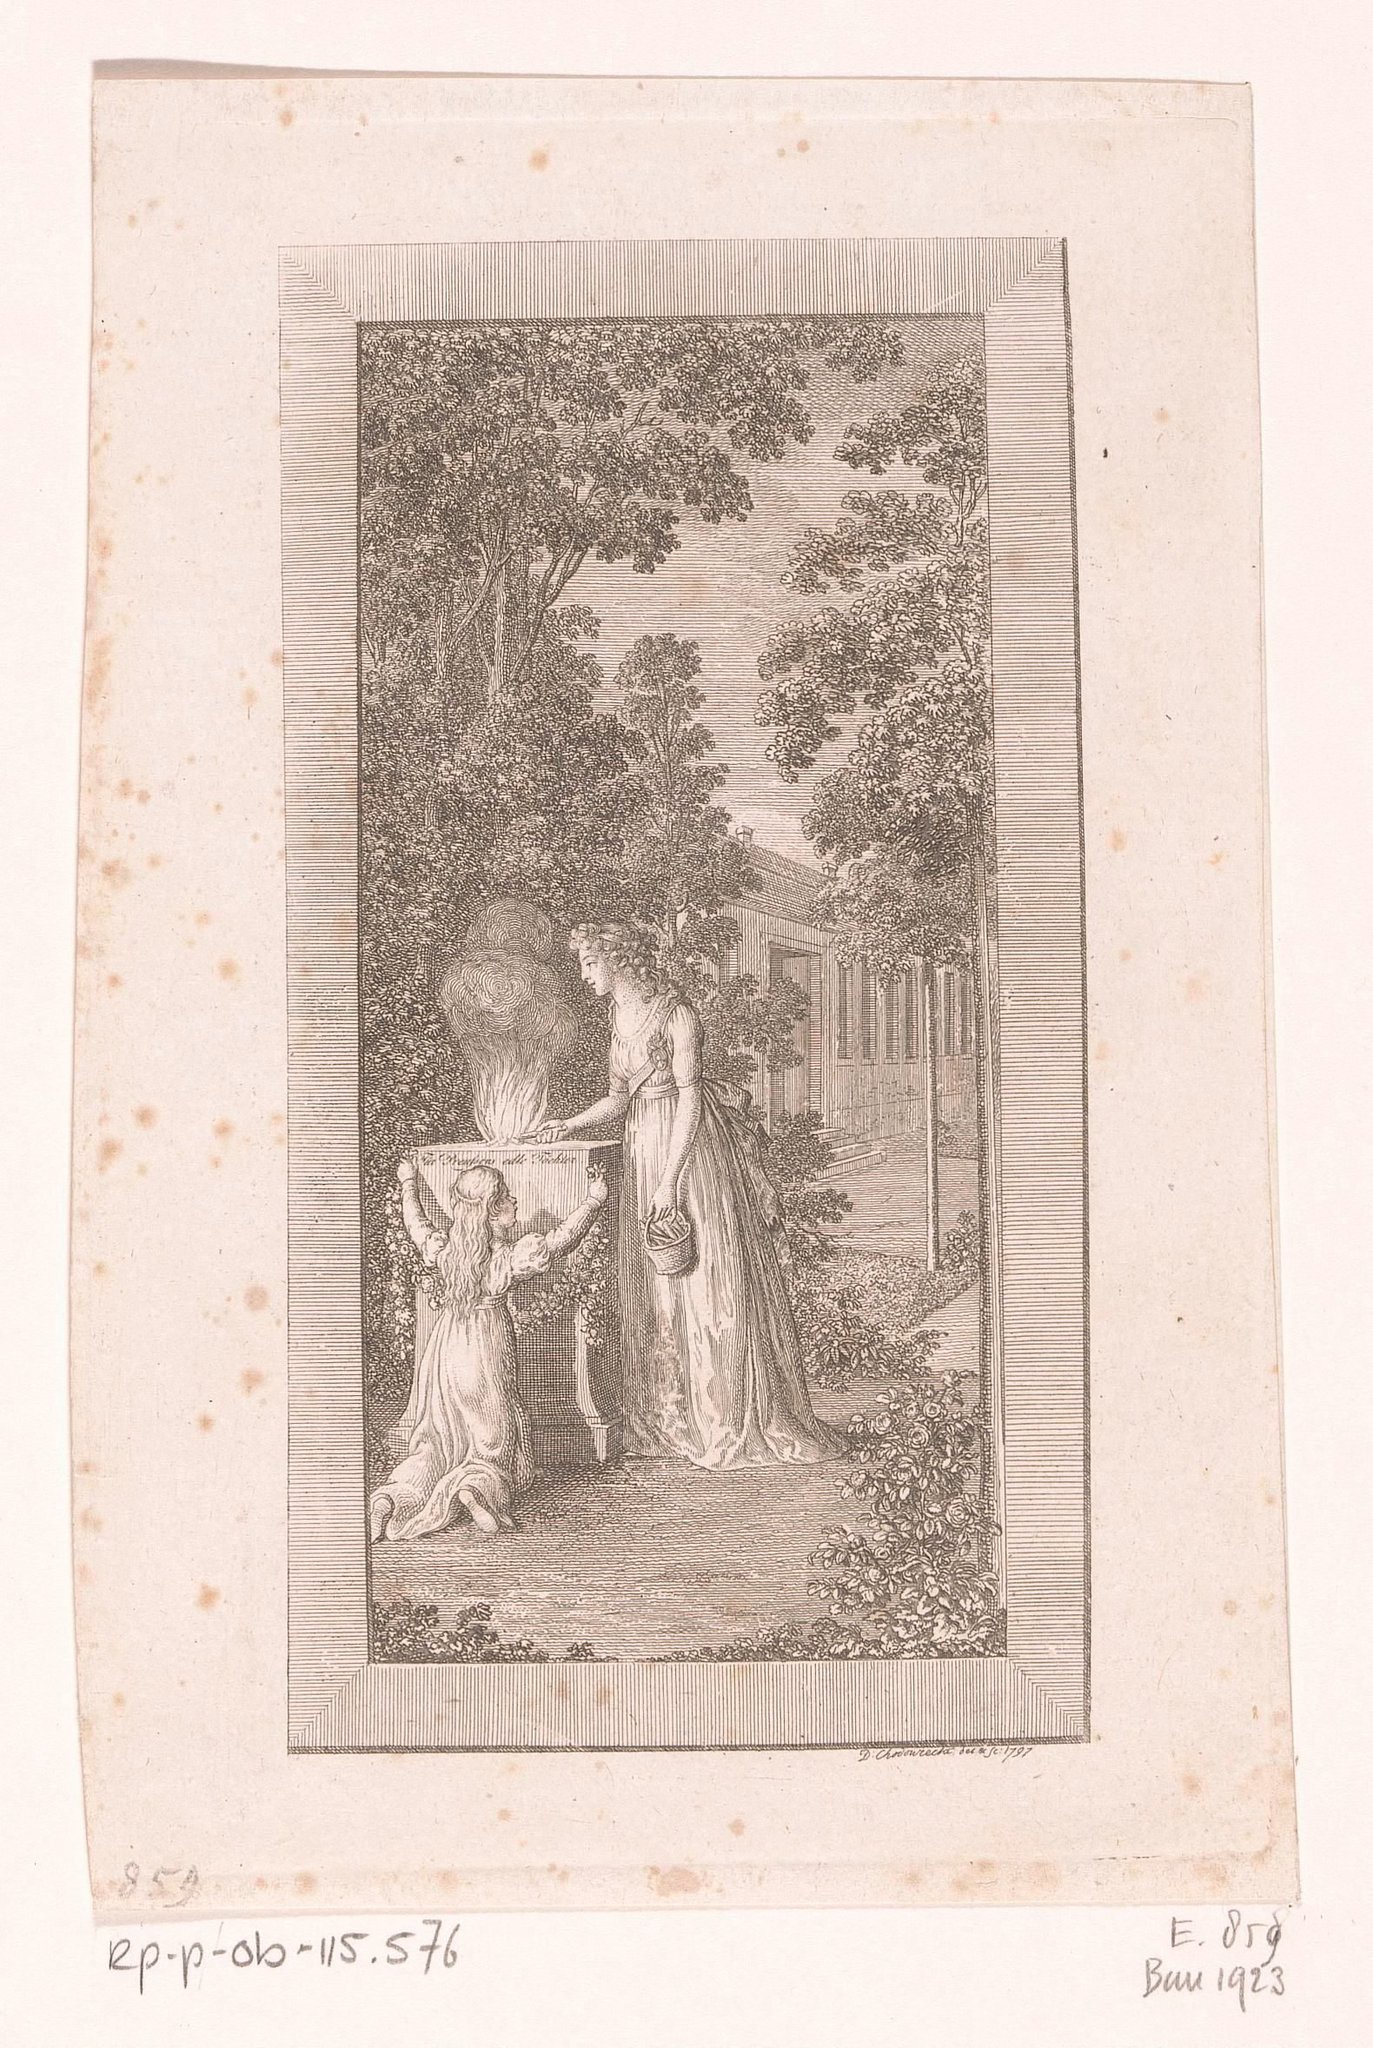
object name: print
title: Jonge vrouw en meisje brengen een offer aan Pruisen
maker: daniel nikolaus chodowiecki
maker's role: draughtsman, print maker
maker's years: 1726-1801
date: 1797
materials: paper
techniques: etching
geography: berlin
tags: offering; 'offerta overo oblatione' (ripa), adolescent, young woman, maiden, child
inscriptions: collector's mark: Lugt 2228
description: Prent gebruikt voor: Krockow, Luise von. Wohlthätige Vorschläge zur Erziehung hülfloser Mädchens aller Stände (...). Berlijn: Schöne, 1797.